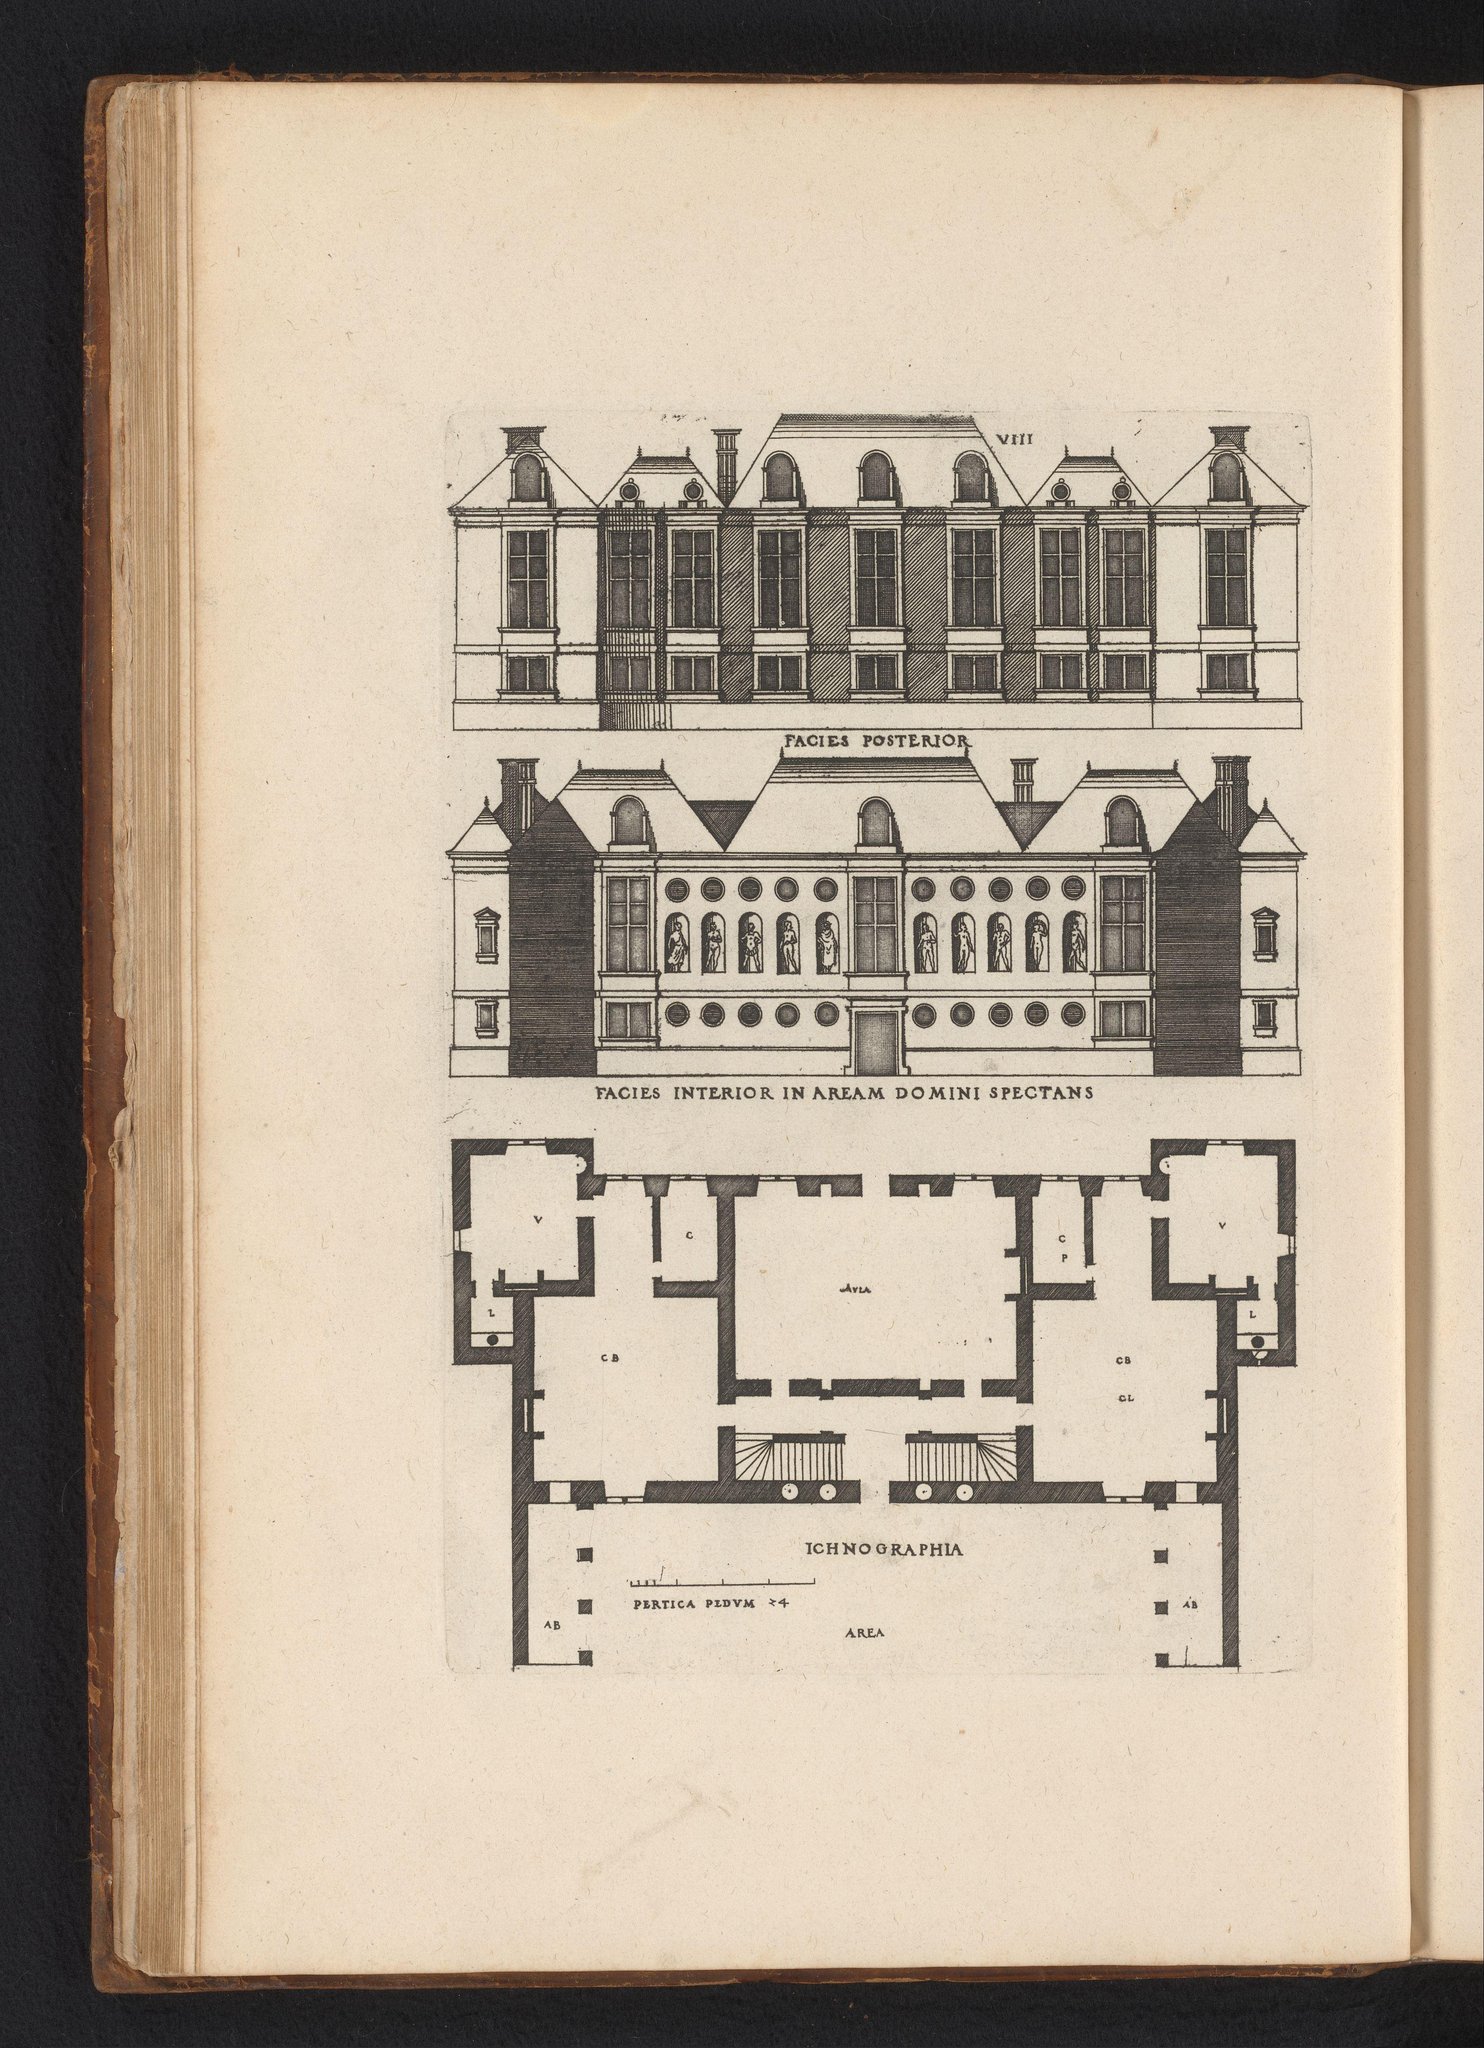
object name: ornament print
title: Voor- en achtergevel en plattegrond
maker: jacques androuet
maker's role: draughtsman, print maker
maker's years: 1515-1584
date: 1559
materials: paper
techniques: etching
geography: paris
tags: façade (of house or building), plan ~ architecture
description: Voor- en achtergevel en plattegrond. Aanzichten en plattegrond van architectuur. Genummerd: VIII. Onderdeel van 'De architectura Iacobi Androuetii du Cerceau' (1559): 69 etsen met 171 voorstellingen van architectuur en ornamentiek.